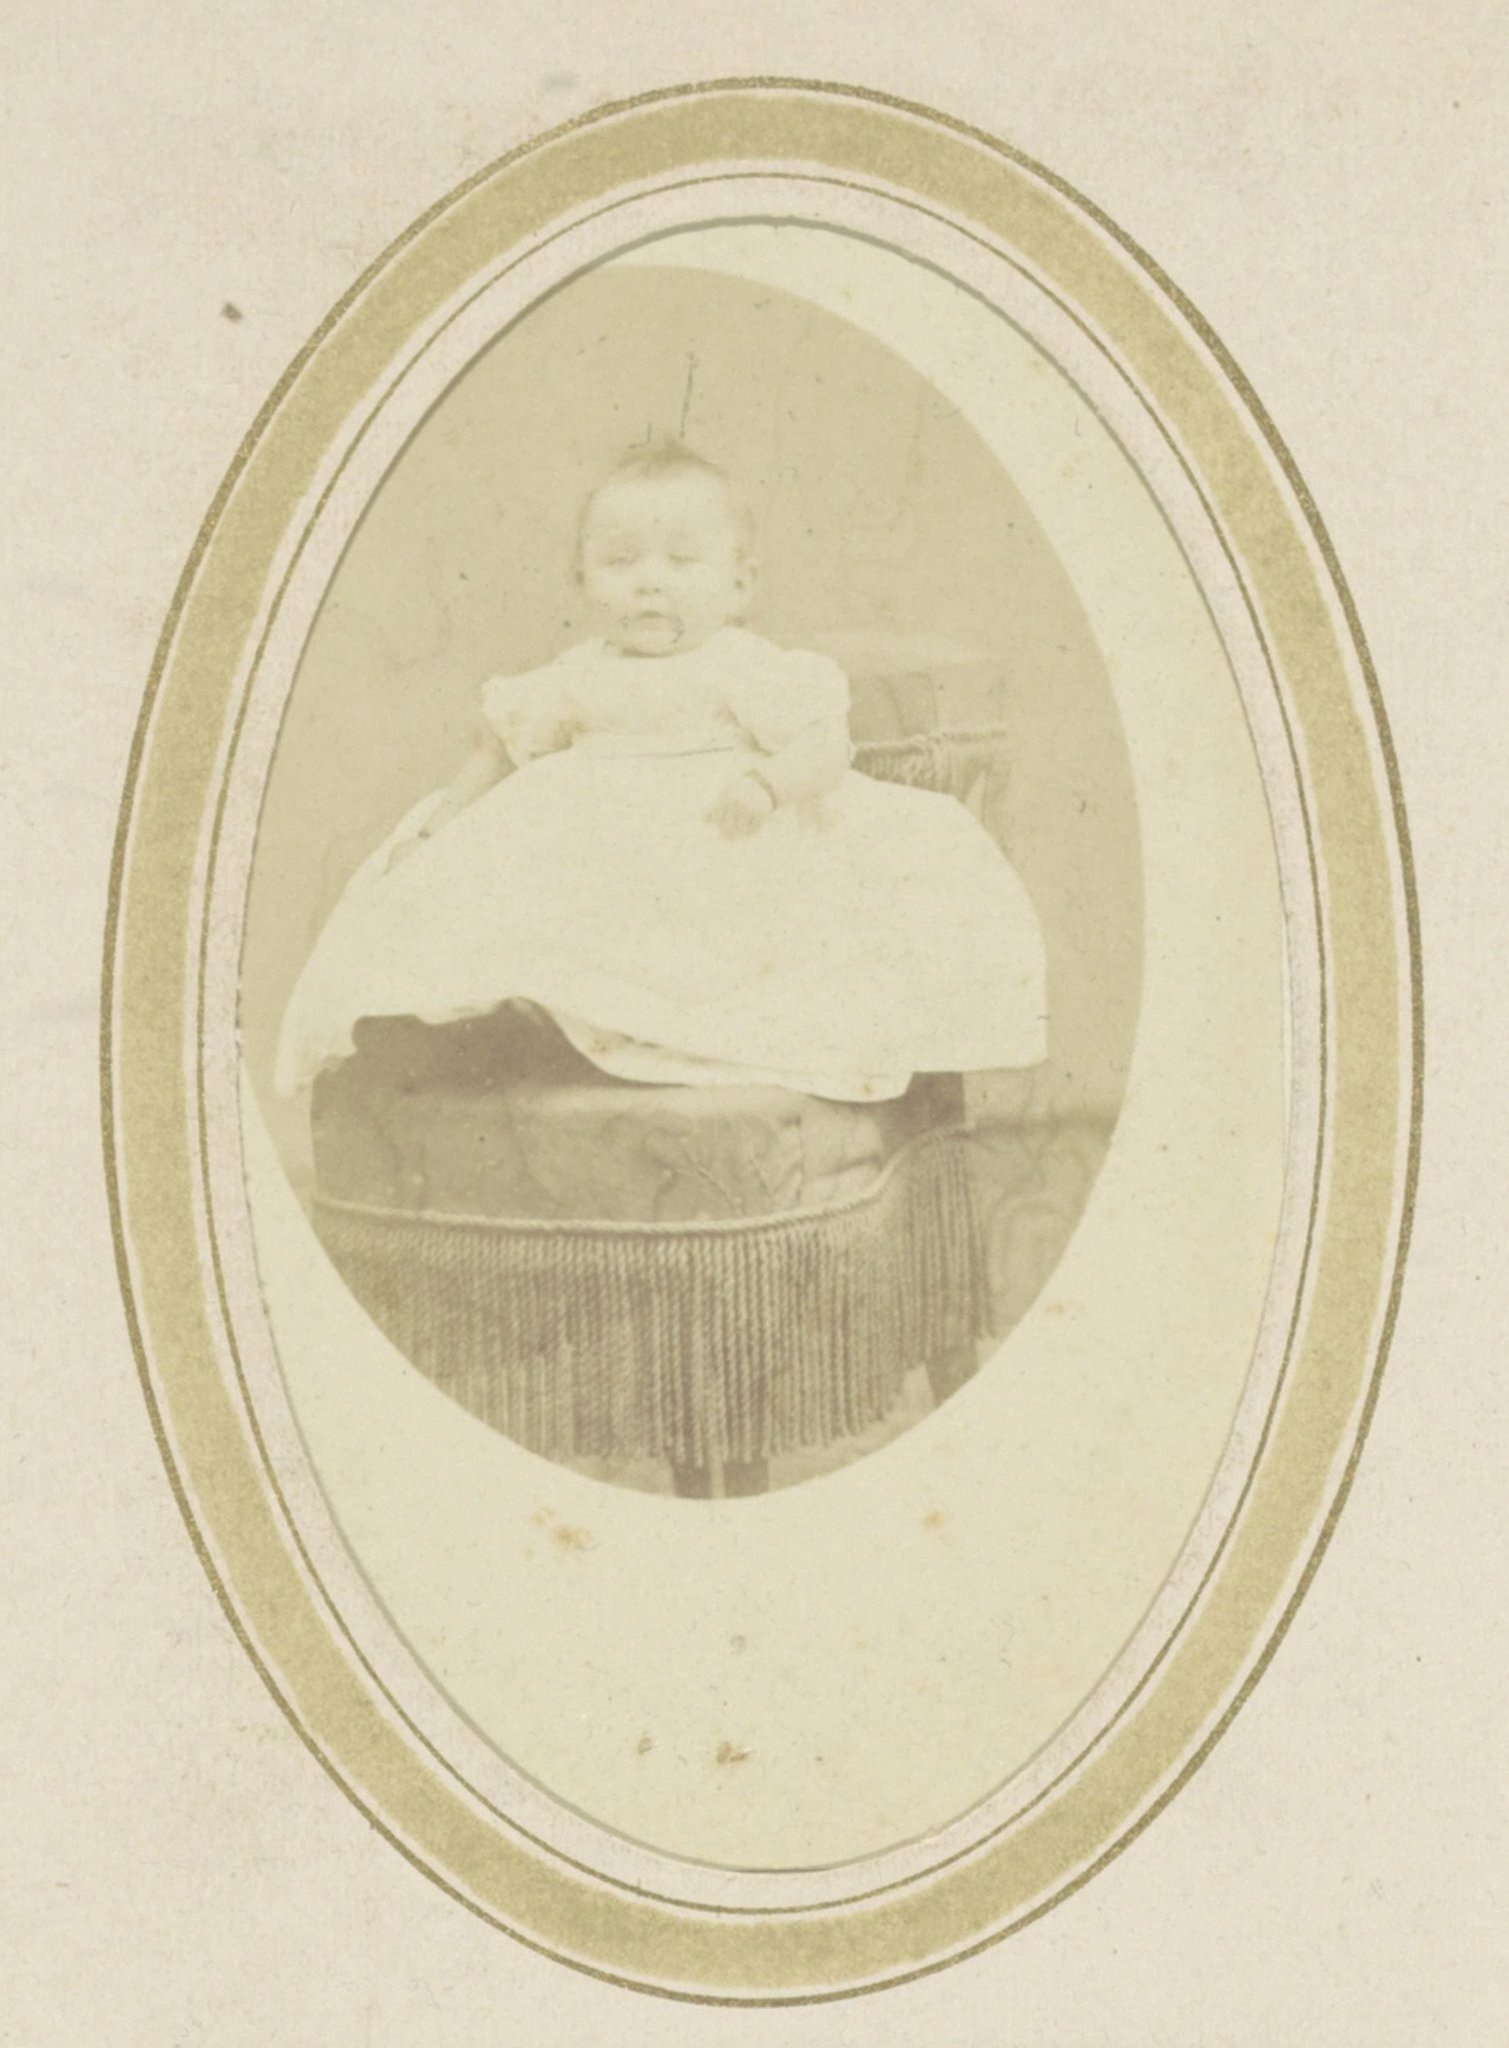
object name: photograph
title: Portret van een baby in een jurk op een fauteuil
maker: Anonymous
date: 1860-1900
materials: cardboard, paper, photographic support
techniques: albumen print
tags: historical persons, clothes covering the entire body, infant, baby ~ the ages of man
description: Onderdeel van Fotoalbum van een Nederlandse familie met 168 cartes-de-visite en kabinetfoto's.